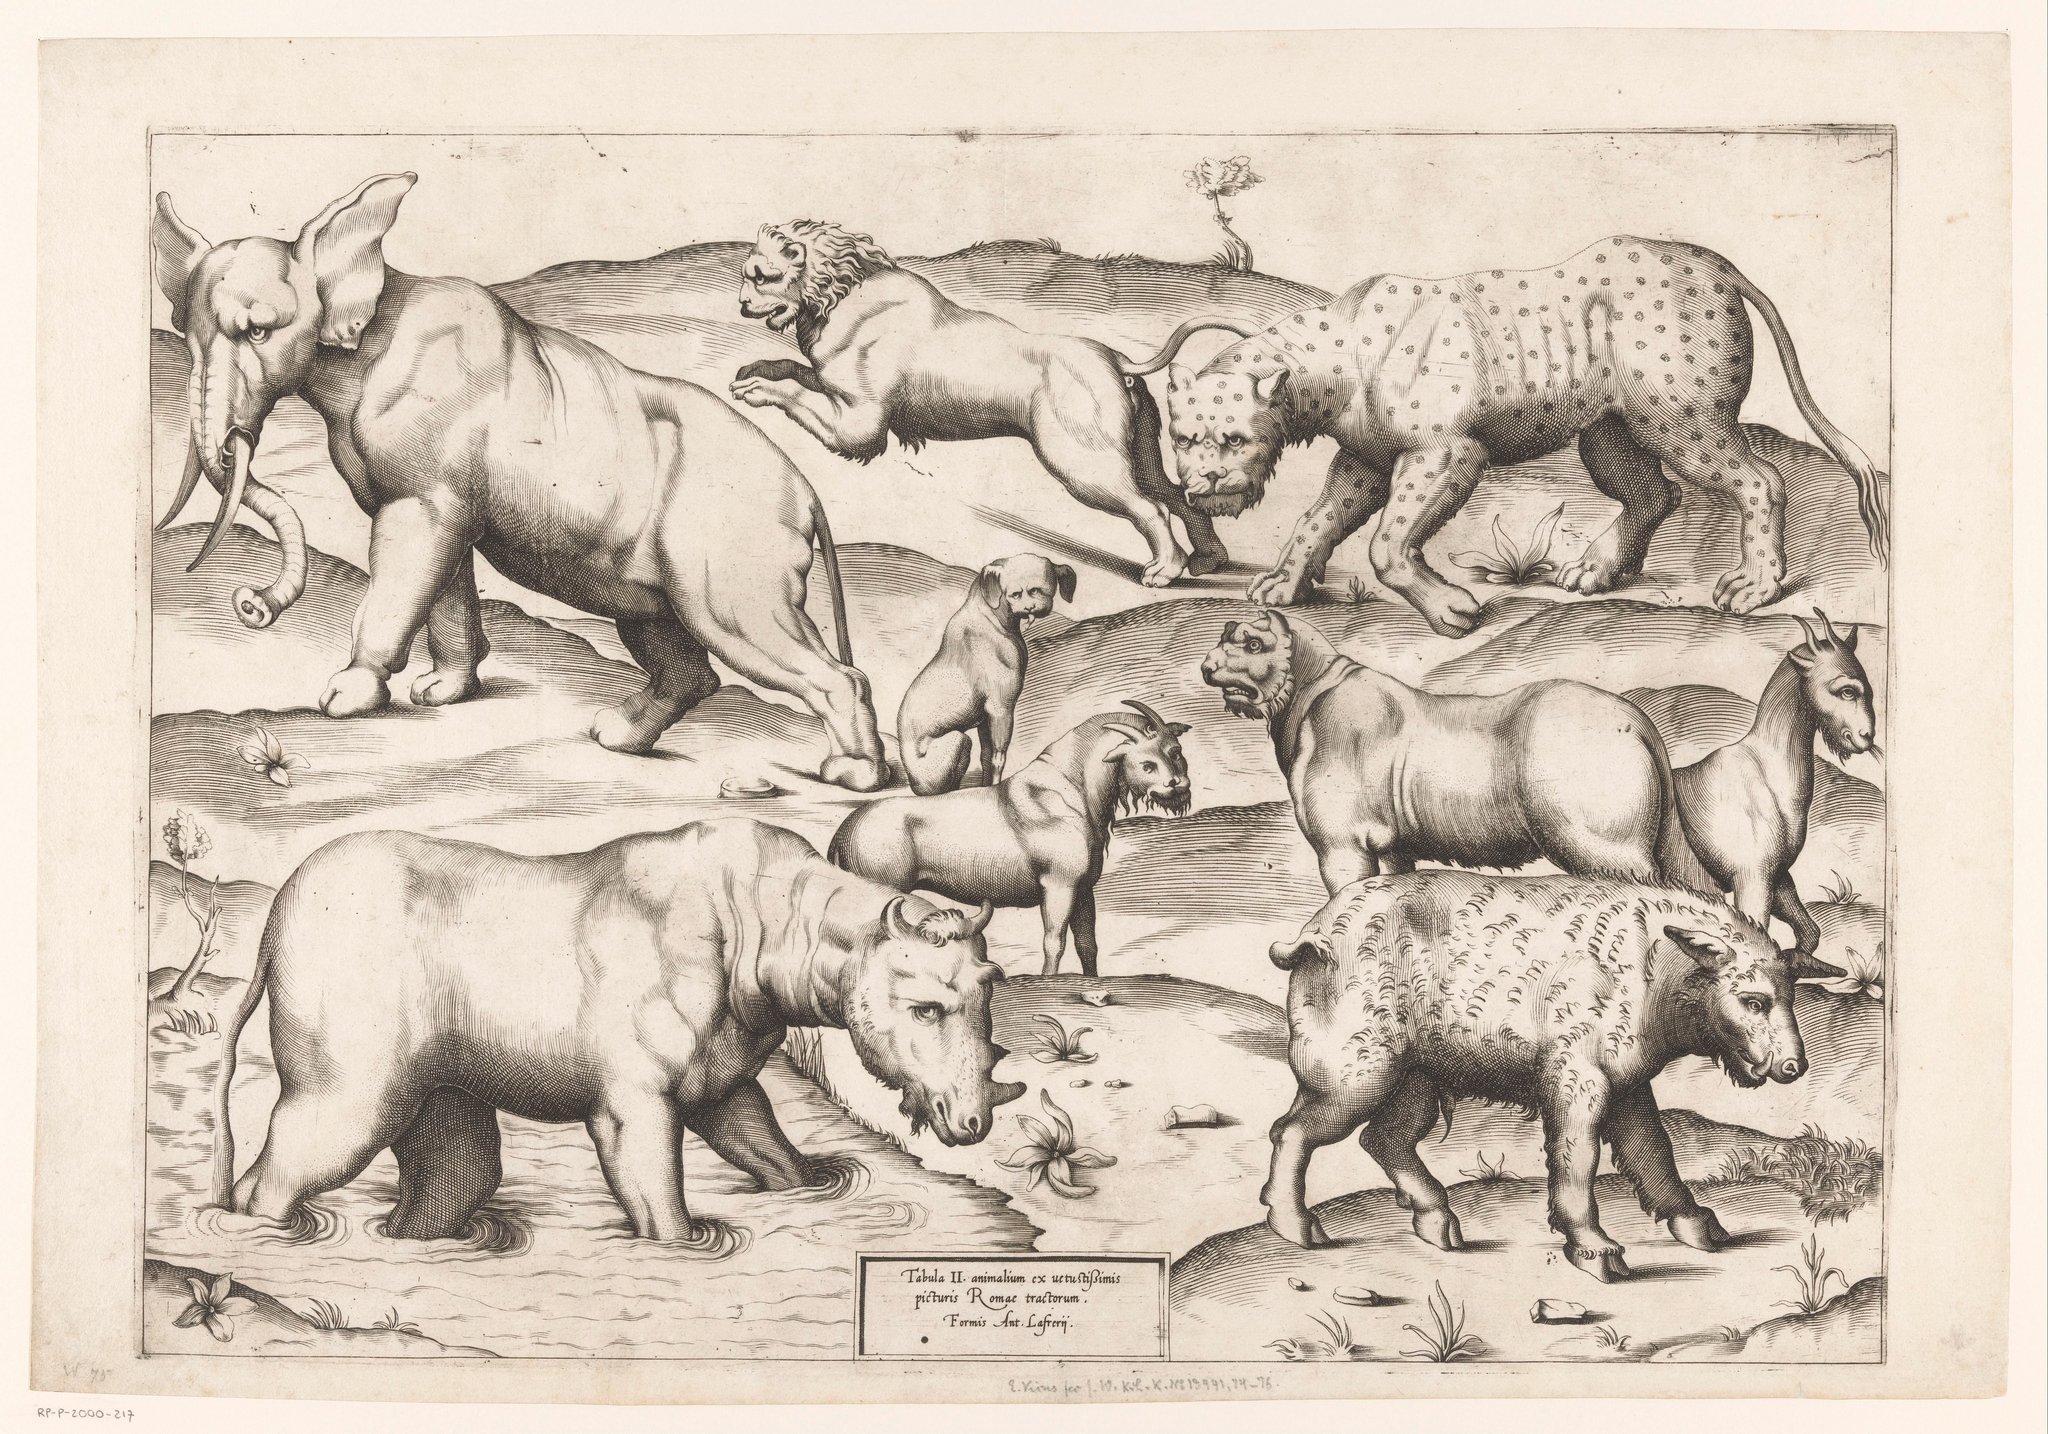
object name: print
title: Negen dieren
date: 1547-1577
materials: paper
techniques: engraving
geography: italy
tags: mammals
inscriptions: collector's mark: Lugt 2760, collector's mark: Lugt 2228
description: Prent uit een reeks van drie prenten met voorstellingen van dieren. Volgens het opschrift op prent nummer I werden de prenten vervaardigd naar in 1547 ontdekte schilderingen in een hypocaustum. Deze prent behoort tot het prentcorpus dat bekend staat als de ‘Speculum Romanae Magnificentiae’ (‘Spiegel van Romeinse pracht’). Dit corpus, bestaande uit prenten met voorstellingen van kunstwerken en gebouwen uit het antieke en het moderne Rome, vond zijn oorsprong bij uitgevers Antonio Salamanca en Antonio Lafreri. Deze twee buitenlandse uitgevers bundelden hun krachten te Rome in de periode 1553-1563. Hun prenten werden al snel razend populair bij toeristen en verzamelaars, die de prenten individueel of in grote groepen aanschaften. Grote groepen Speculum-prenten werden vaak op aanvraag samengebonden in albums. Er zijn verschillende Speculum-albums overgeleverd die allemaal verschillen van inhoud. Tussen 1573 en 1577 gaf Antonio Lafreri een speciale titelpagina uit (met de titel ‘Speculum Romanae Magnificentiae’) die mensen voor hun verzamelingen konden voegen. Het overlijden van Lafreri in 1577 betekende niet het einde van het corpus. Een groot deel van de koperplaten ging over op Claudio en Stefano Duchetti. De rest raakte verspreid over verschillende andere uitgevers. De populariteit van de Speculum-prenten wist nog geruime periode uitgevers te inspireren tot het laten maken van kopieën en het toevoegen van nieuwe prenten aan het corpus.